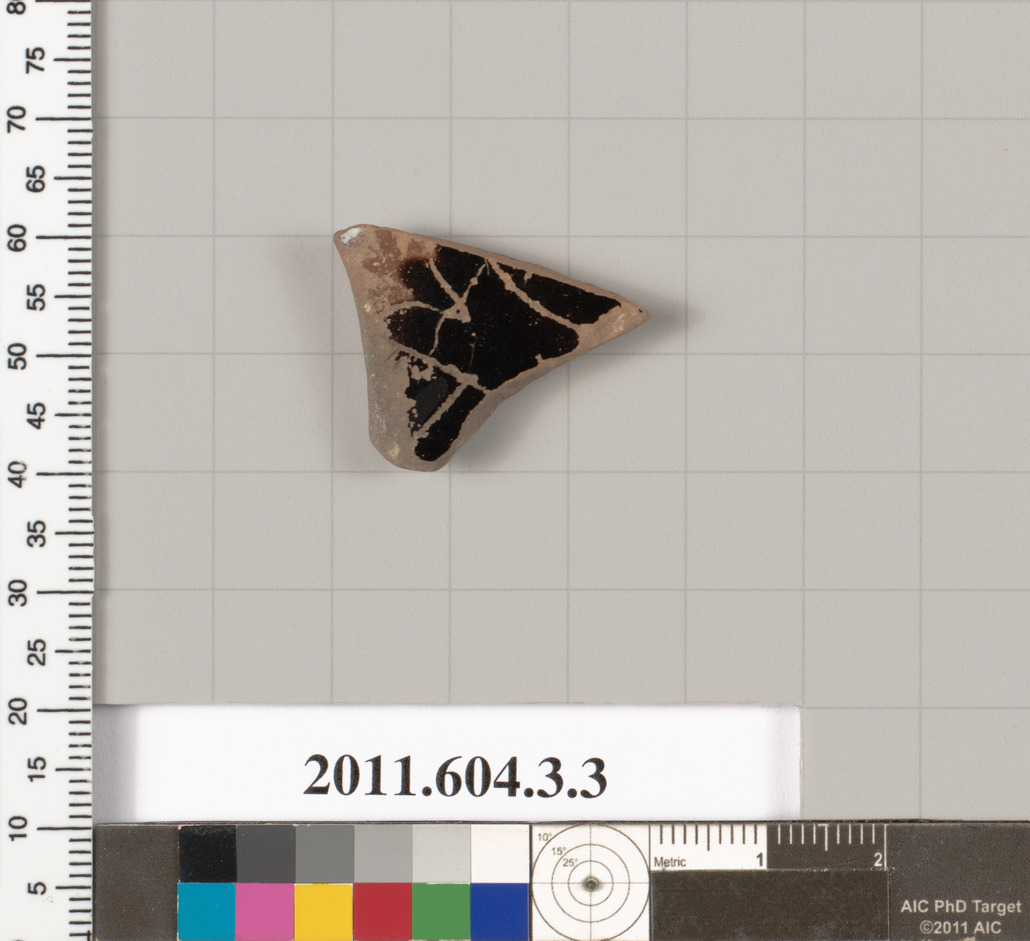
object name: kylix fragment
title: Terracotta fragment of a kylix (drinking cup)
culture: greek, attic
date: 534-468 BCE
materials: terracotta